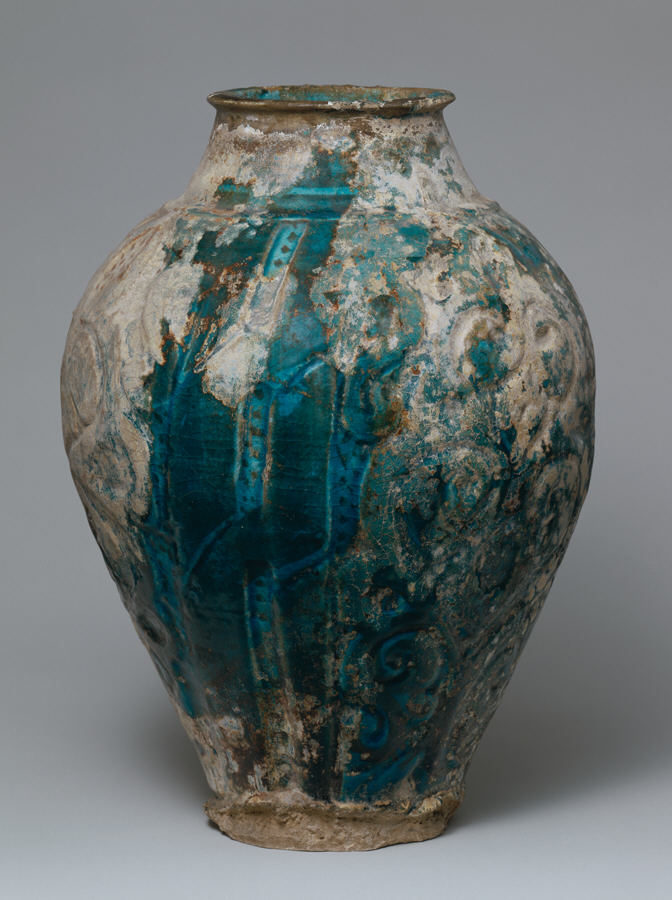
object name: jar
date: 1101-1200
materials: stonepaste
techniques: painting, underglaze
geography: syria